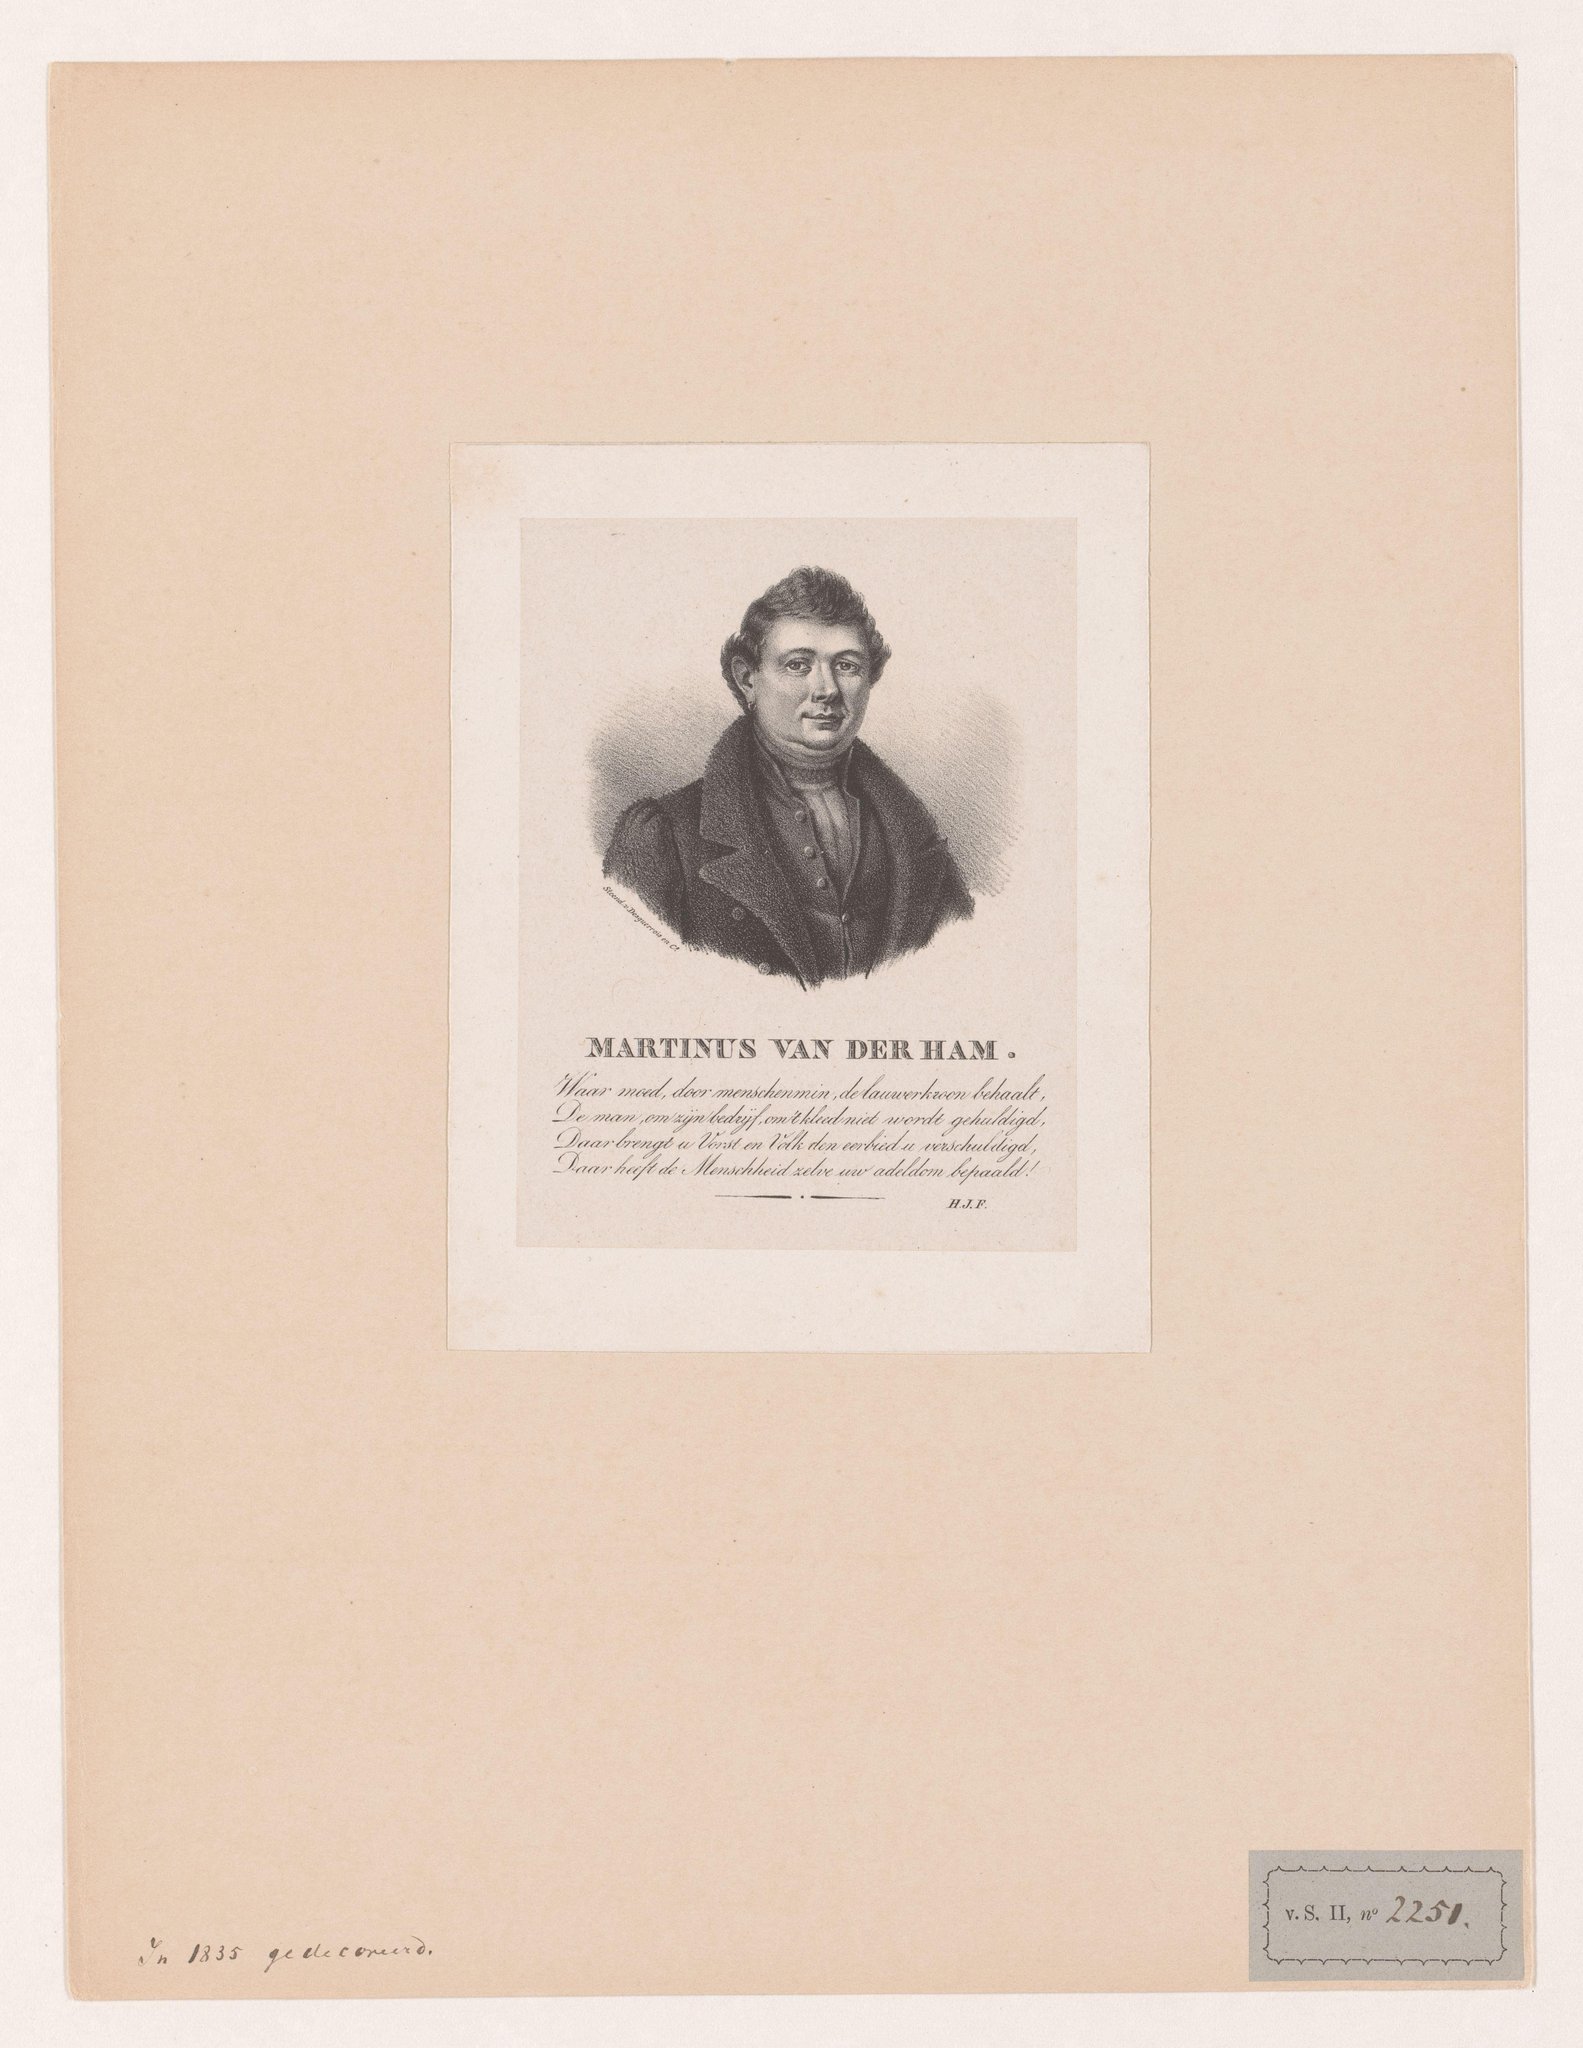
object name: print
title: Portret van Martinus van der Ham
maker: Anonymous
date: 1834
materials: paper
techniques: lithograph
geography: amsterdam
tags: bergen op zoom, historical persons (+ (full) bust portrait)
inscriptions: collector's mark: Lugt 2228, inscription: ‘In 1835 gedecoreerd.’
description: Onder het portret de naam van de geportretteerde en een vierregelig vers door H. J. Foppe.